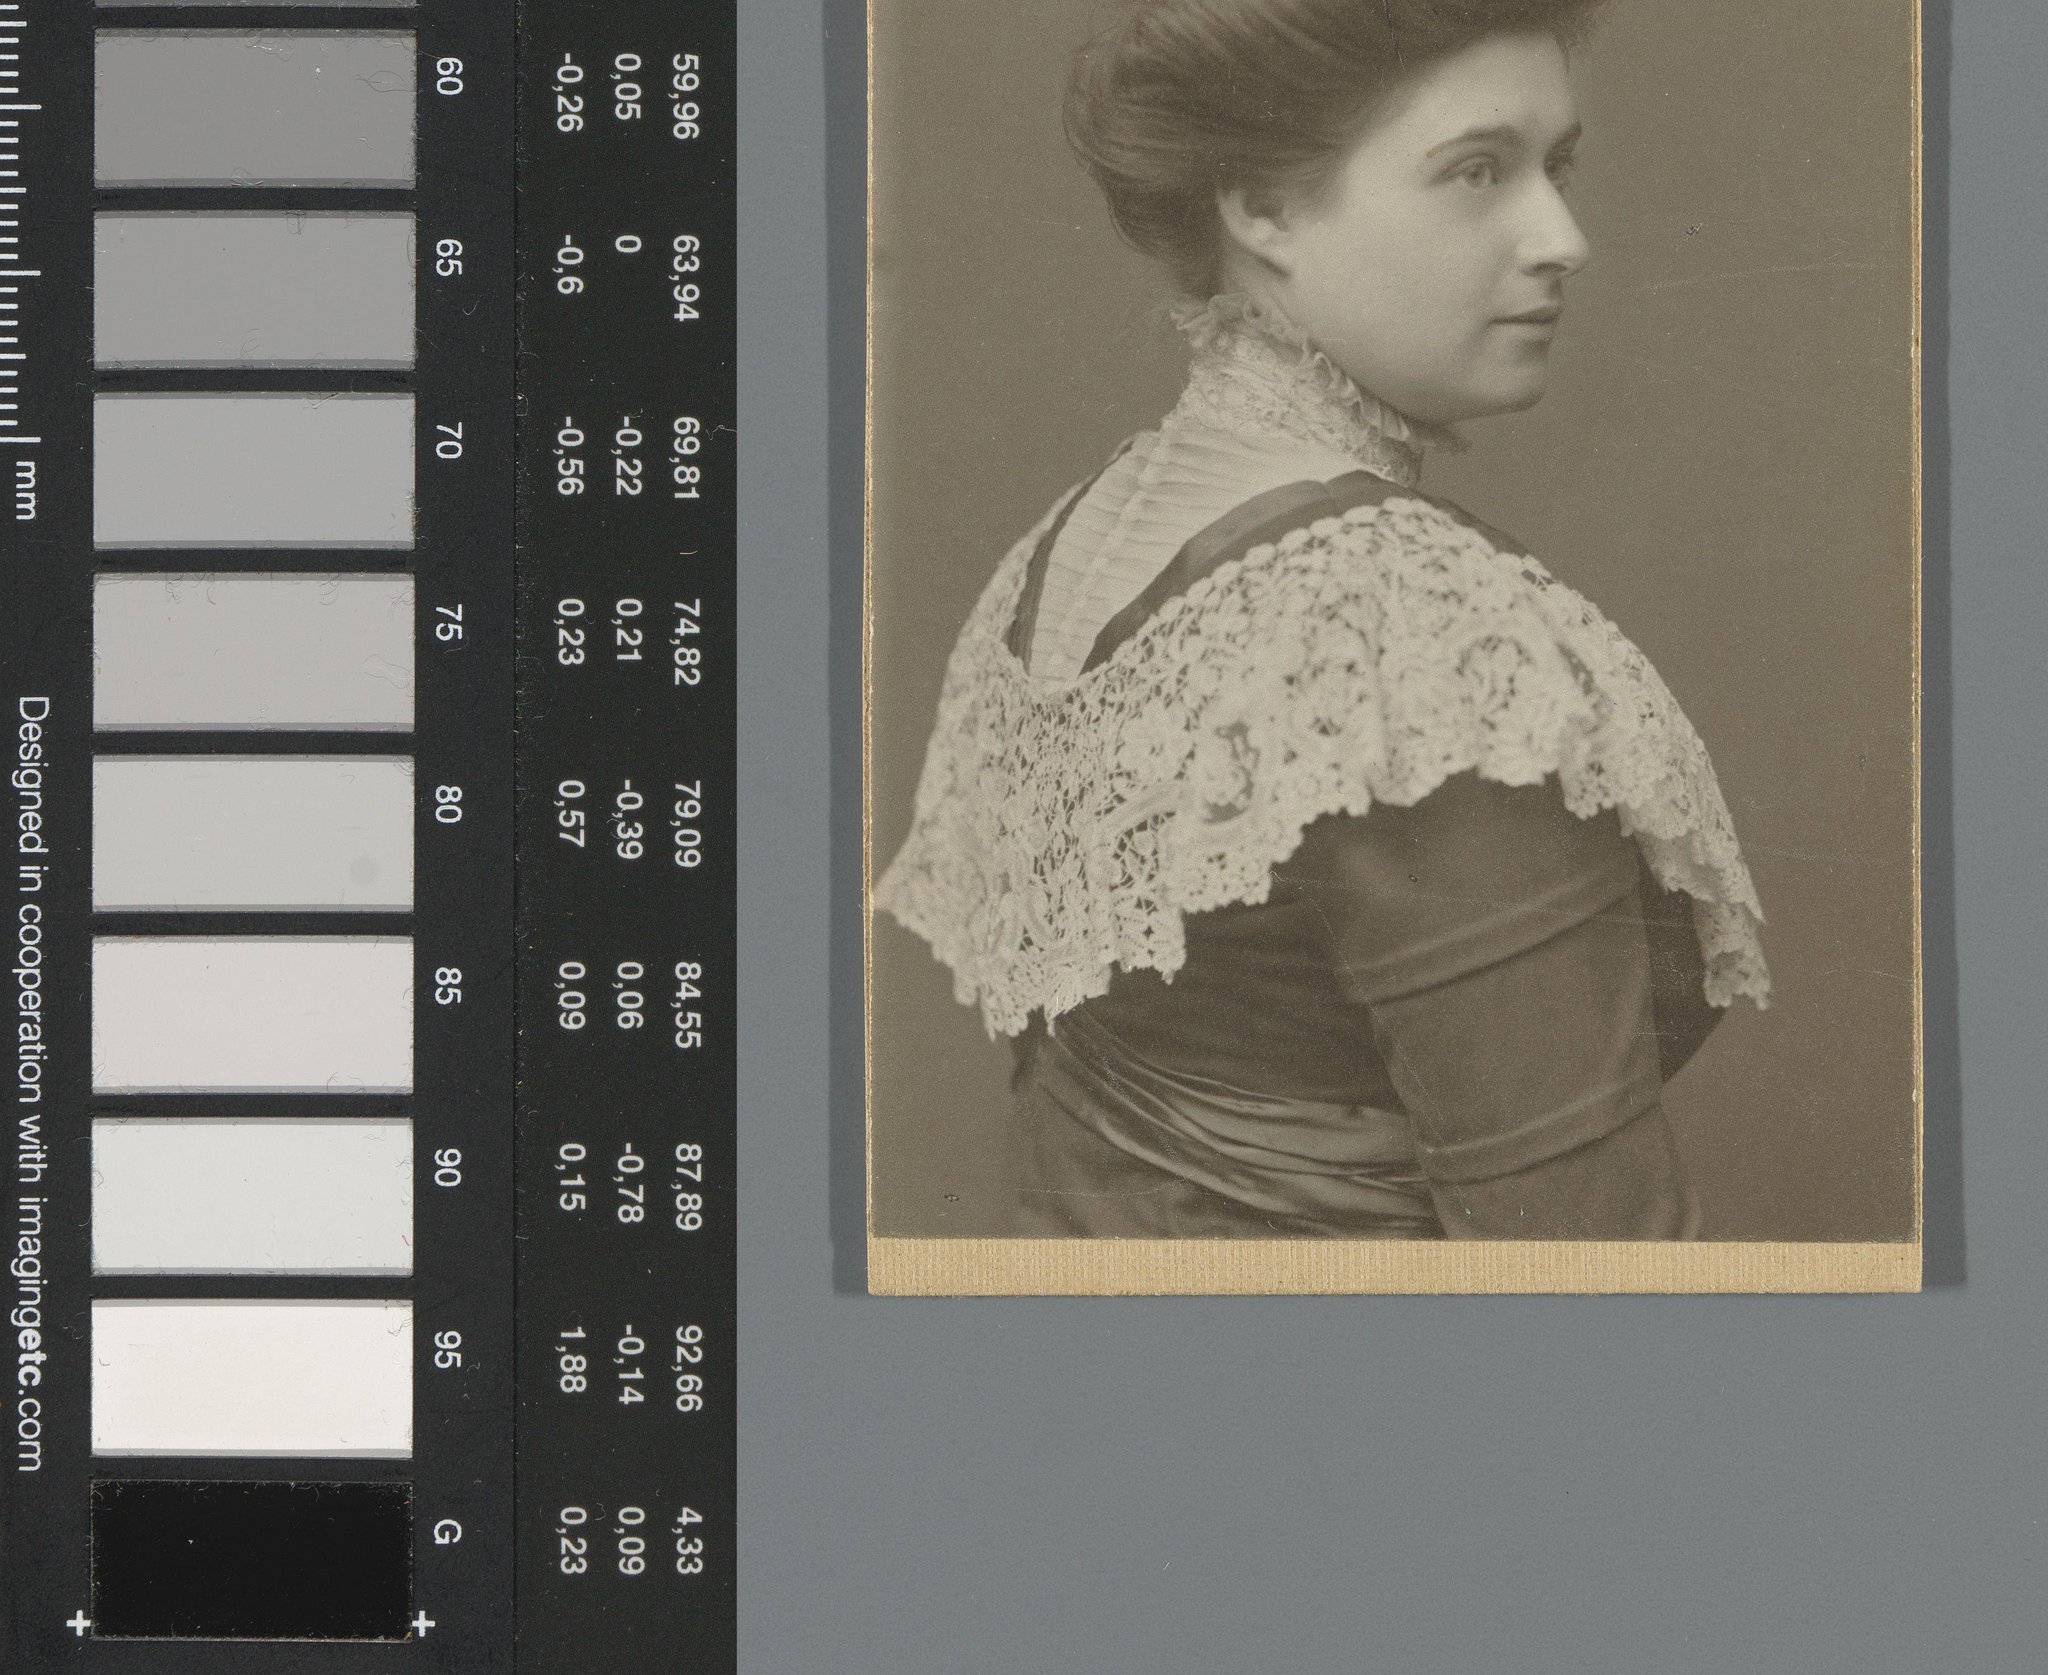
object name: photograph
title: Portret van Anna Maria Johanna van Marle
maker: Anonymous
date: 1908-1915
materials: cardboard, photographic support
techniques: photography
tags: amsterdam, historical persons - bb - woman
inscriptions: annotation: ‘Anna TvB-v.Marle’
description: Portret van Anna Maria Johanna Teding van Berkhout-van Marle.